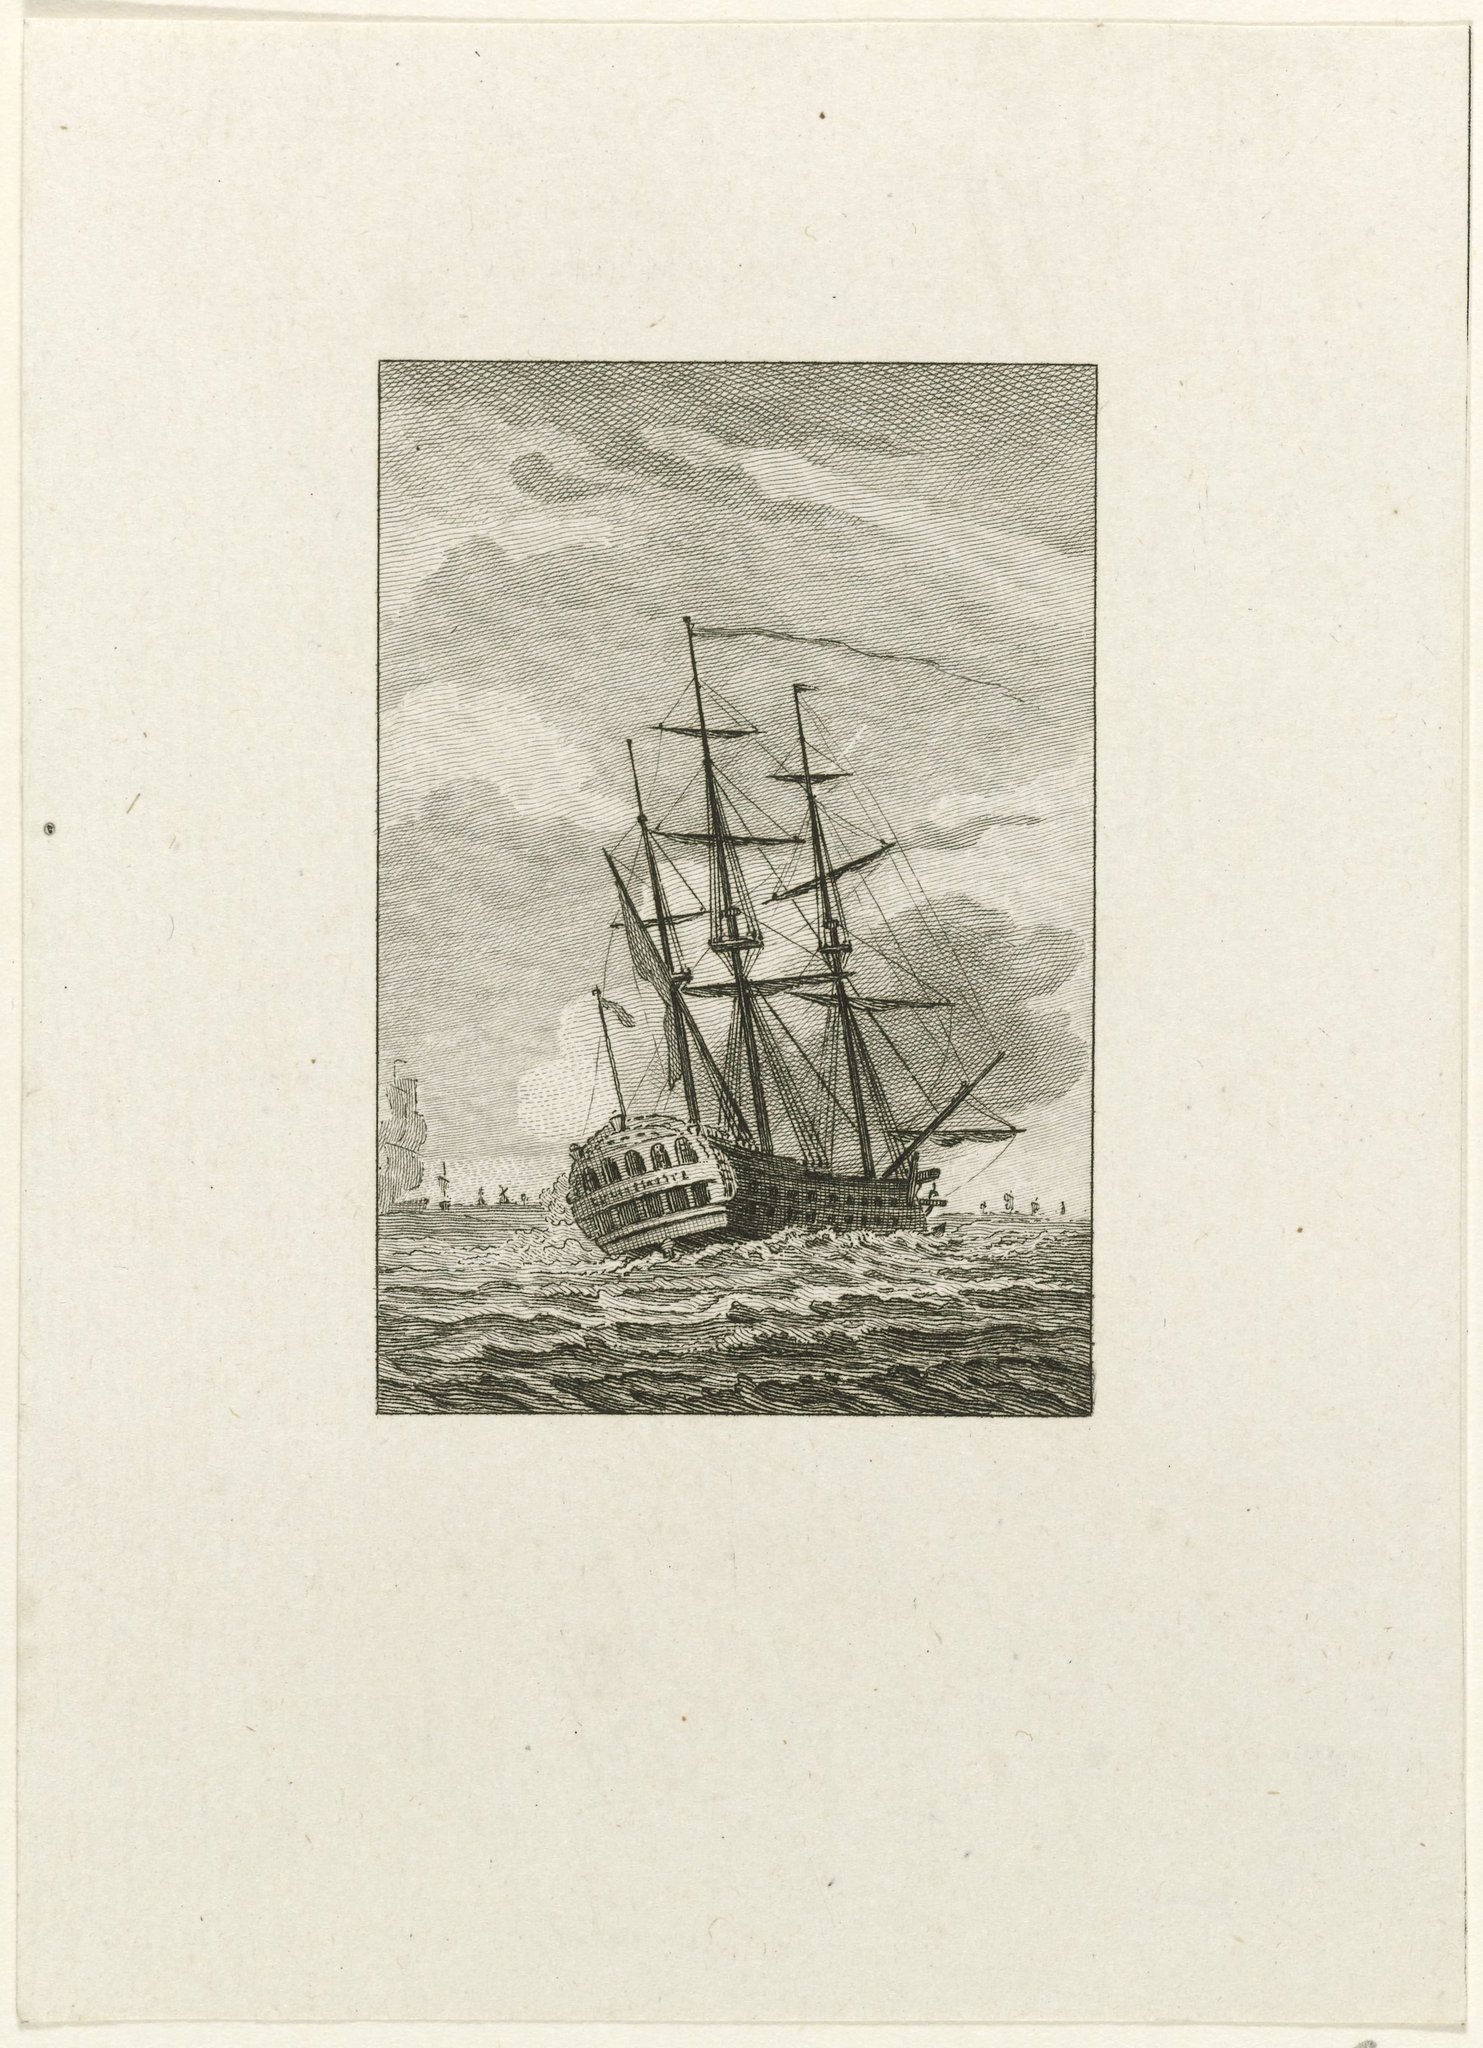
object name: print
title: Verzeilen van het schip Prins Willem, 1781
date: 1781-1795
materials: paper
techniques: engraving, etching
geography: northern netherlands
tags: shipwreck (+ propulsion of vehicle, ship, etc. by wind)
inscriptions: collector's mark: Lugt 2228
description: Gebruikt als illustratie in: J. Fokke, Geschiedenissen der Vereenigde Nederlanden voor de vaderlandsche jeugd, Johannes Allart, Amsterdam 1783-1795, 25 delen.